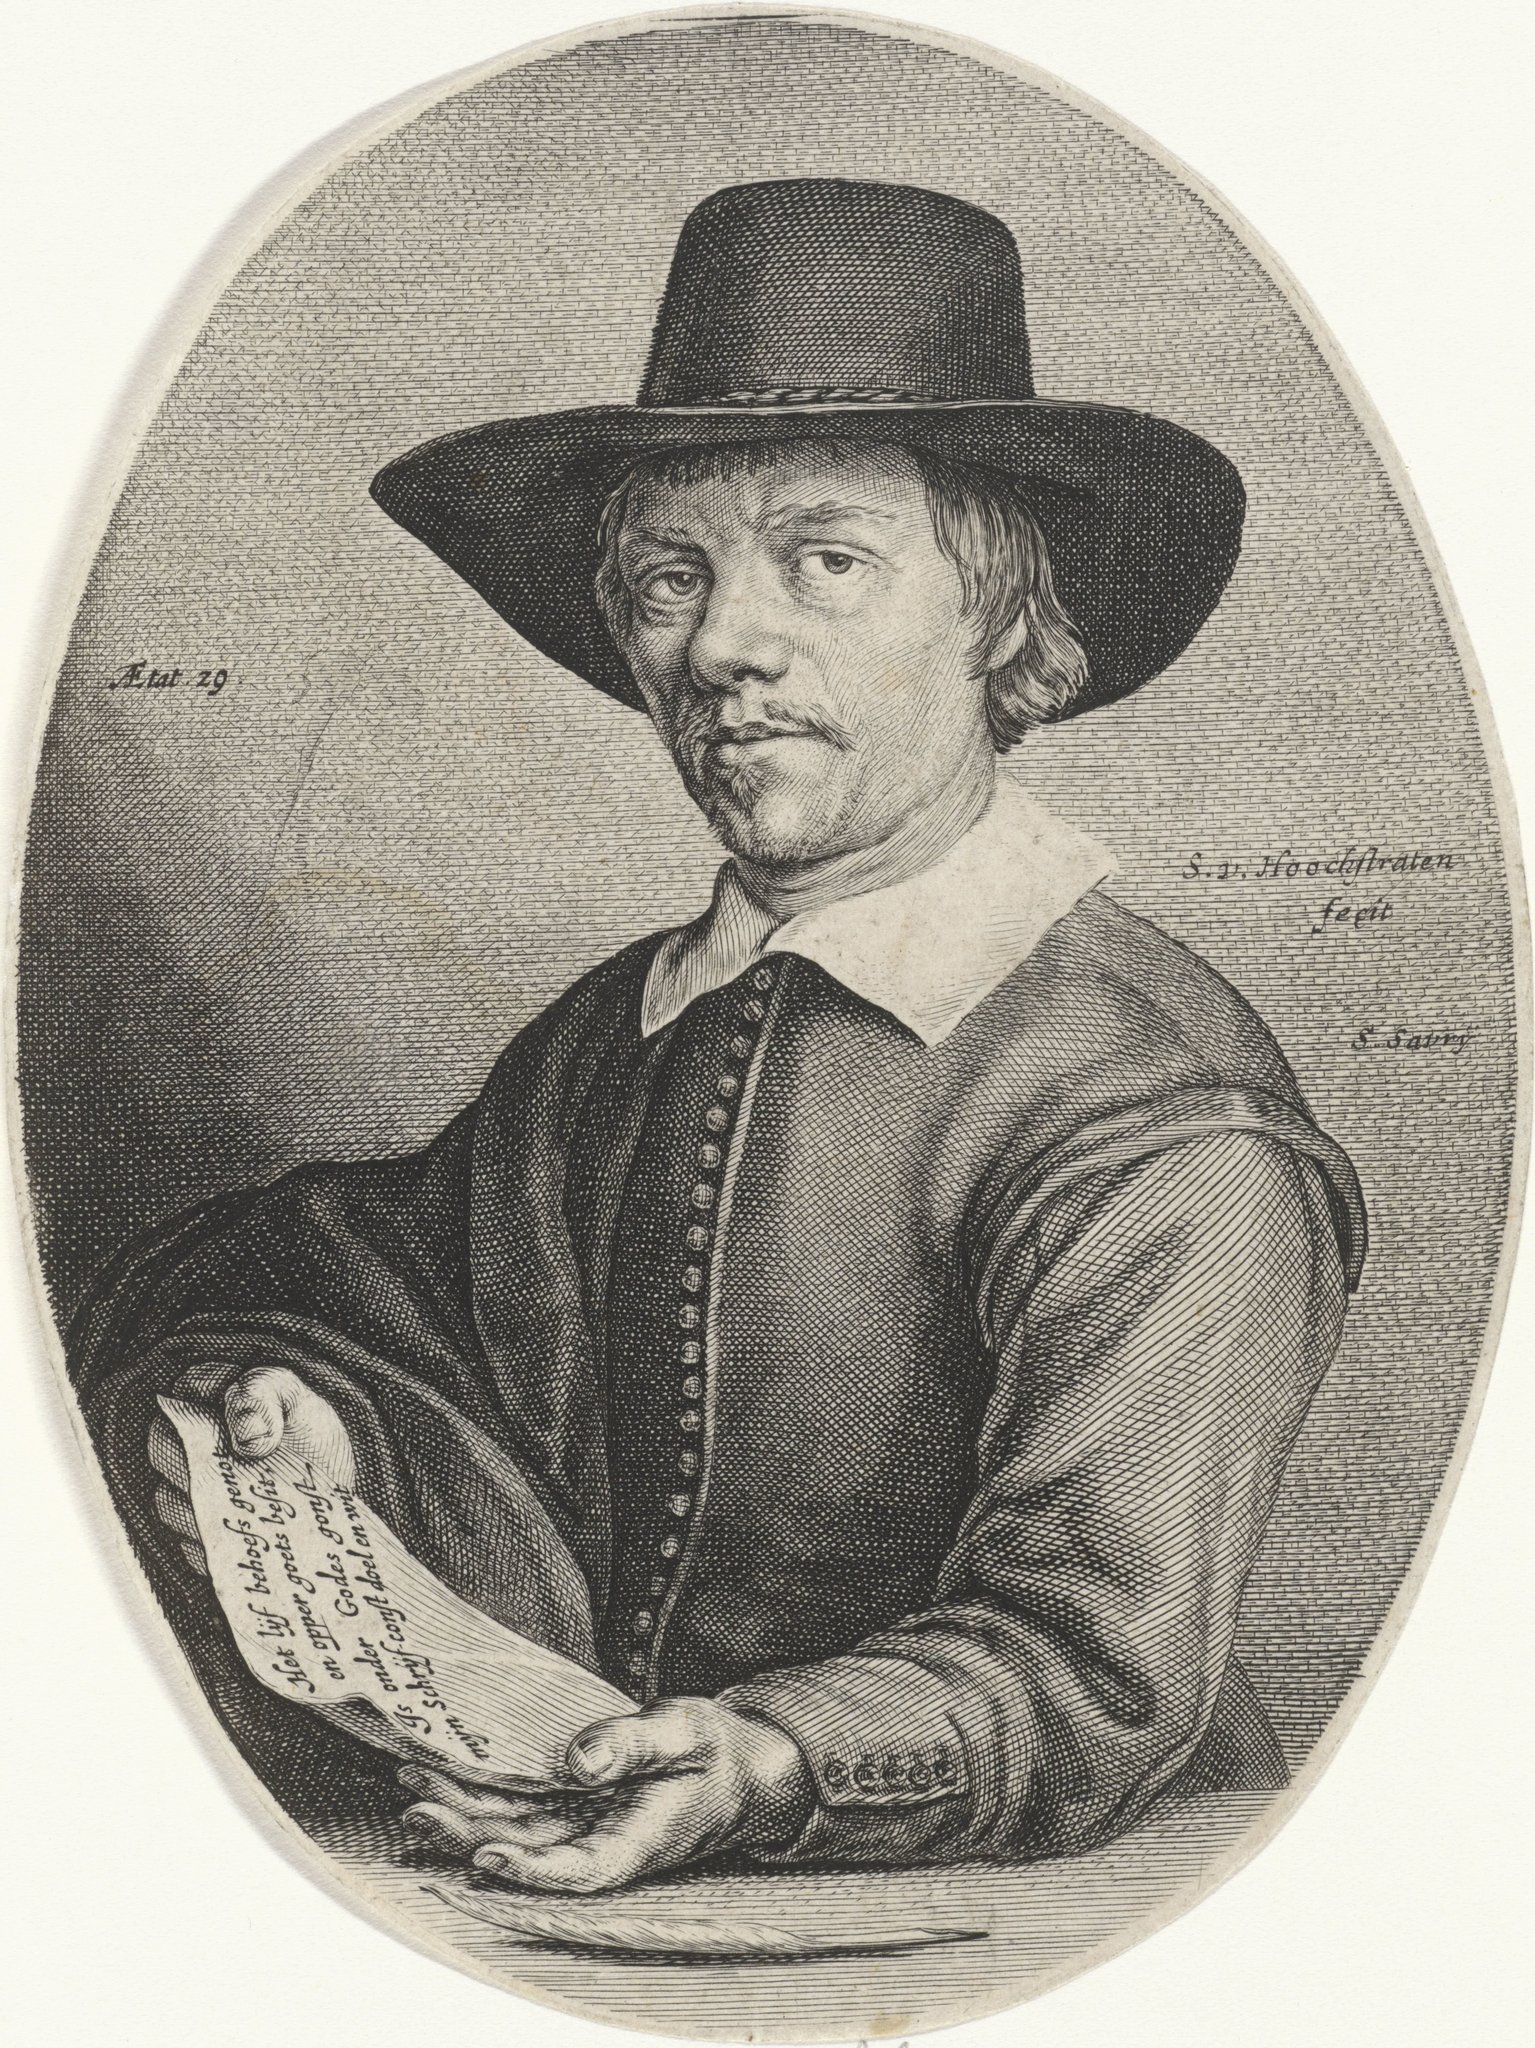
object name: print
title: Portret van de schoolmeester en schoonschrijver Theodore Bleuet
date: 1637-1665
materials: paper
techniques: engraving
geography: amsterdam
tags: schoolmeester, theodore bleuet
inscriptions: collector's mark: Lugt 964